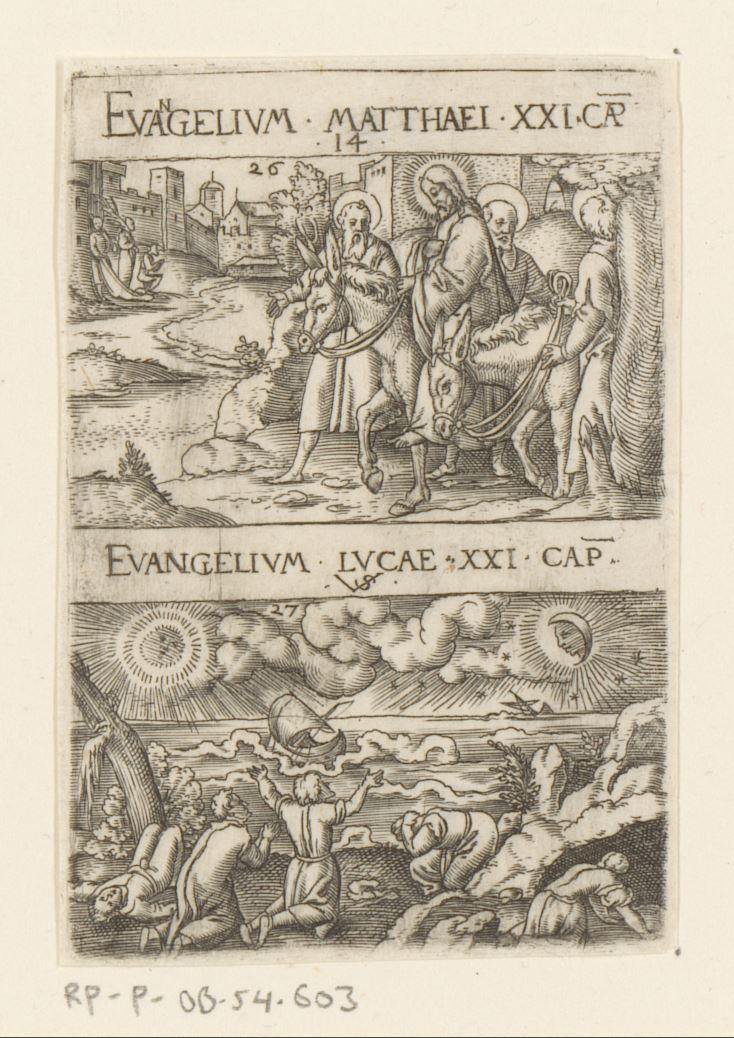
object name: print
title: Intocht in Jeruzalem en Christus voorspelt het einde der tijden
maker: virgilius solis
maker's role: draughtsman, print maker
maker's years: 1514-1562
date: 1524-1562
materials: paper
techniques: engraving, etching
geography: nuremberg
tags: entry into jerusalem: people spreading their clothes before christ on the ass, and waving palm branches (matthew 21:1-11, 21:14-16; mark 11:1-11; luke 19:28-40; john 12:12-19), sayings of christ: discourse on the last things (matthew 24; mark 13; luke 21)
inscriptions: collector's mark: Lugt 2228, number: ‘88’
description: Deze prent maakt deel uit van een serie bestaande uit 27 genummerde prenten. De prenten tonen steeds twee evangelische scènes boven elkaar. Alle voorstellingen behalve de bovenste van de eerste prent zijn eveneens afzonderlijk genummerd.